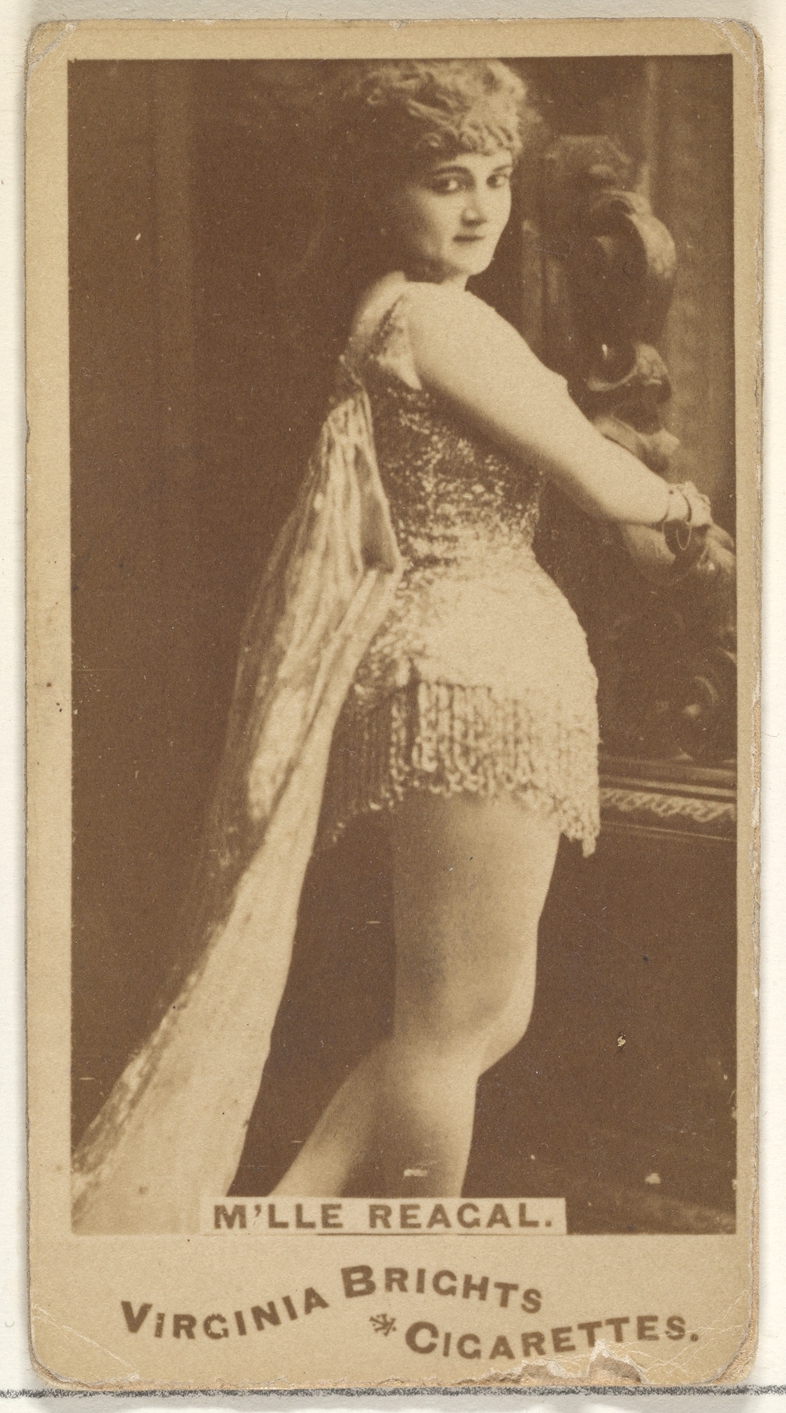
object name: photograph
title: M'lle Reagal, from the Actors and Actresses series (N45, Type 1) for Virginia Brights Cigarettes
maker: allen & ginter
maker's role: publisher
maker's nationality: american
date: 1888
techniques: albumen silver print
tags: portraits,women,actresses